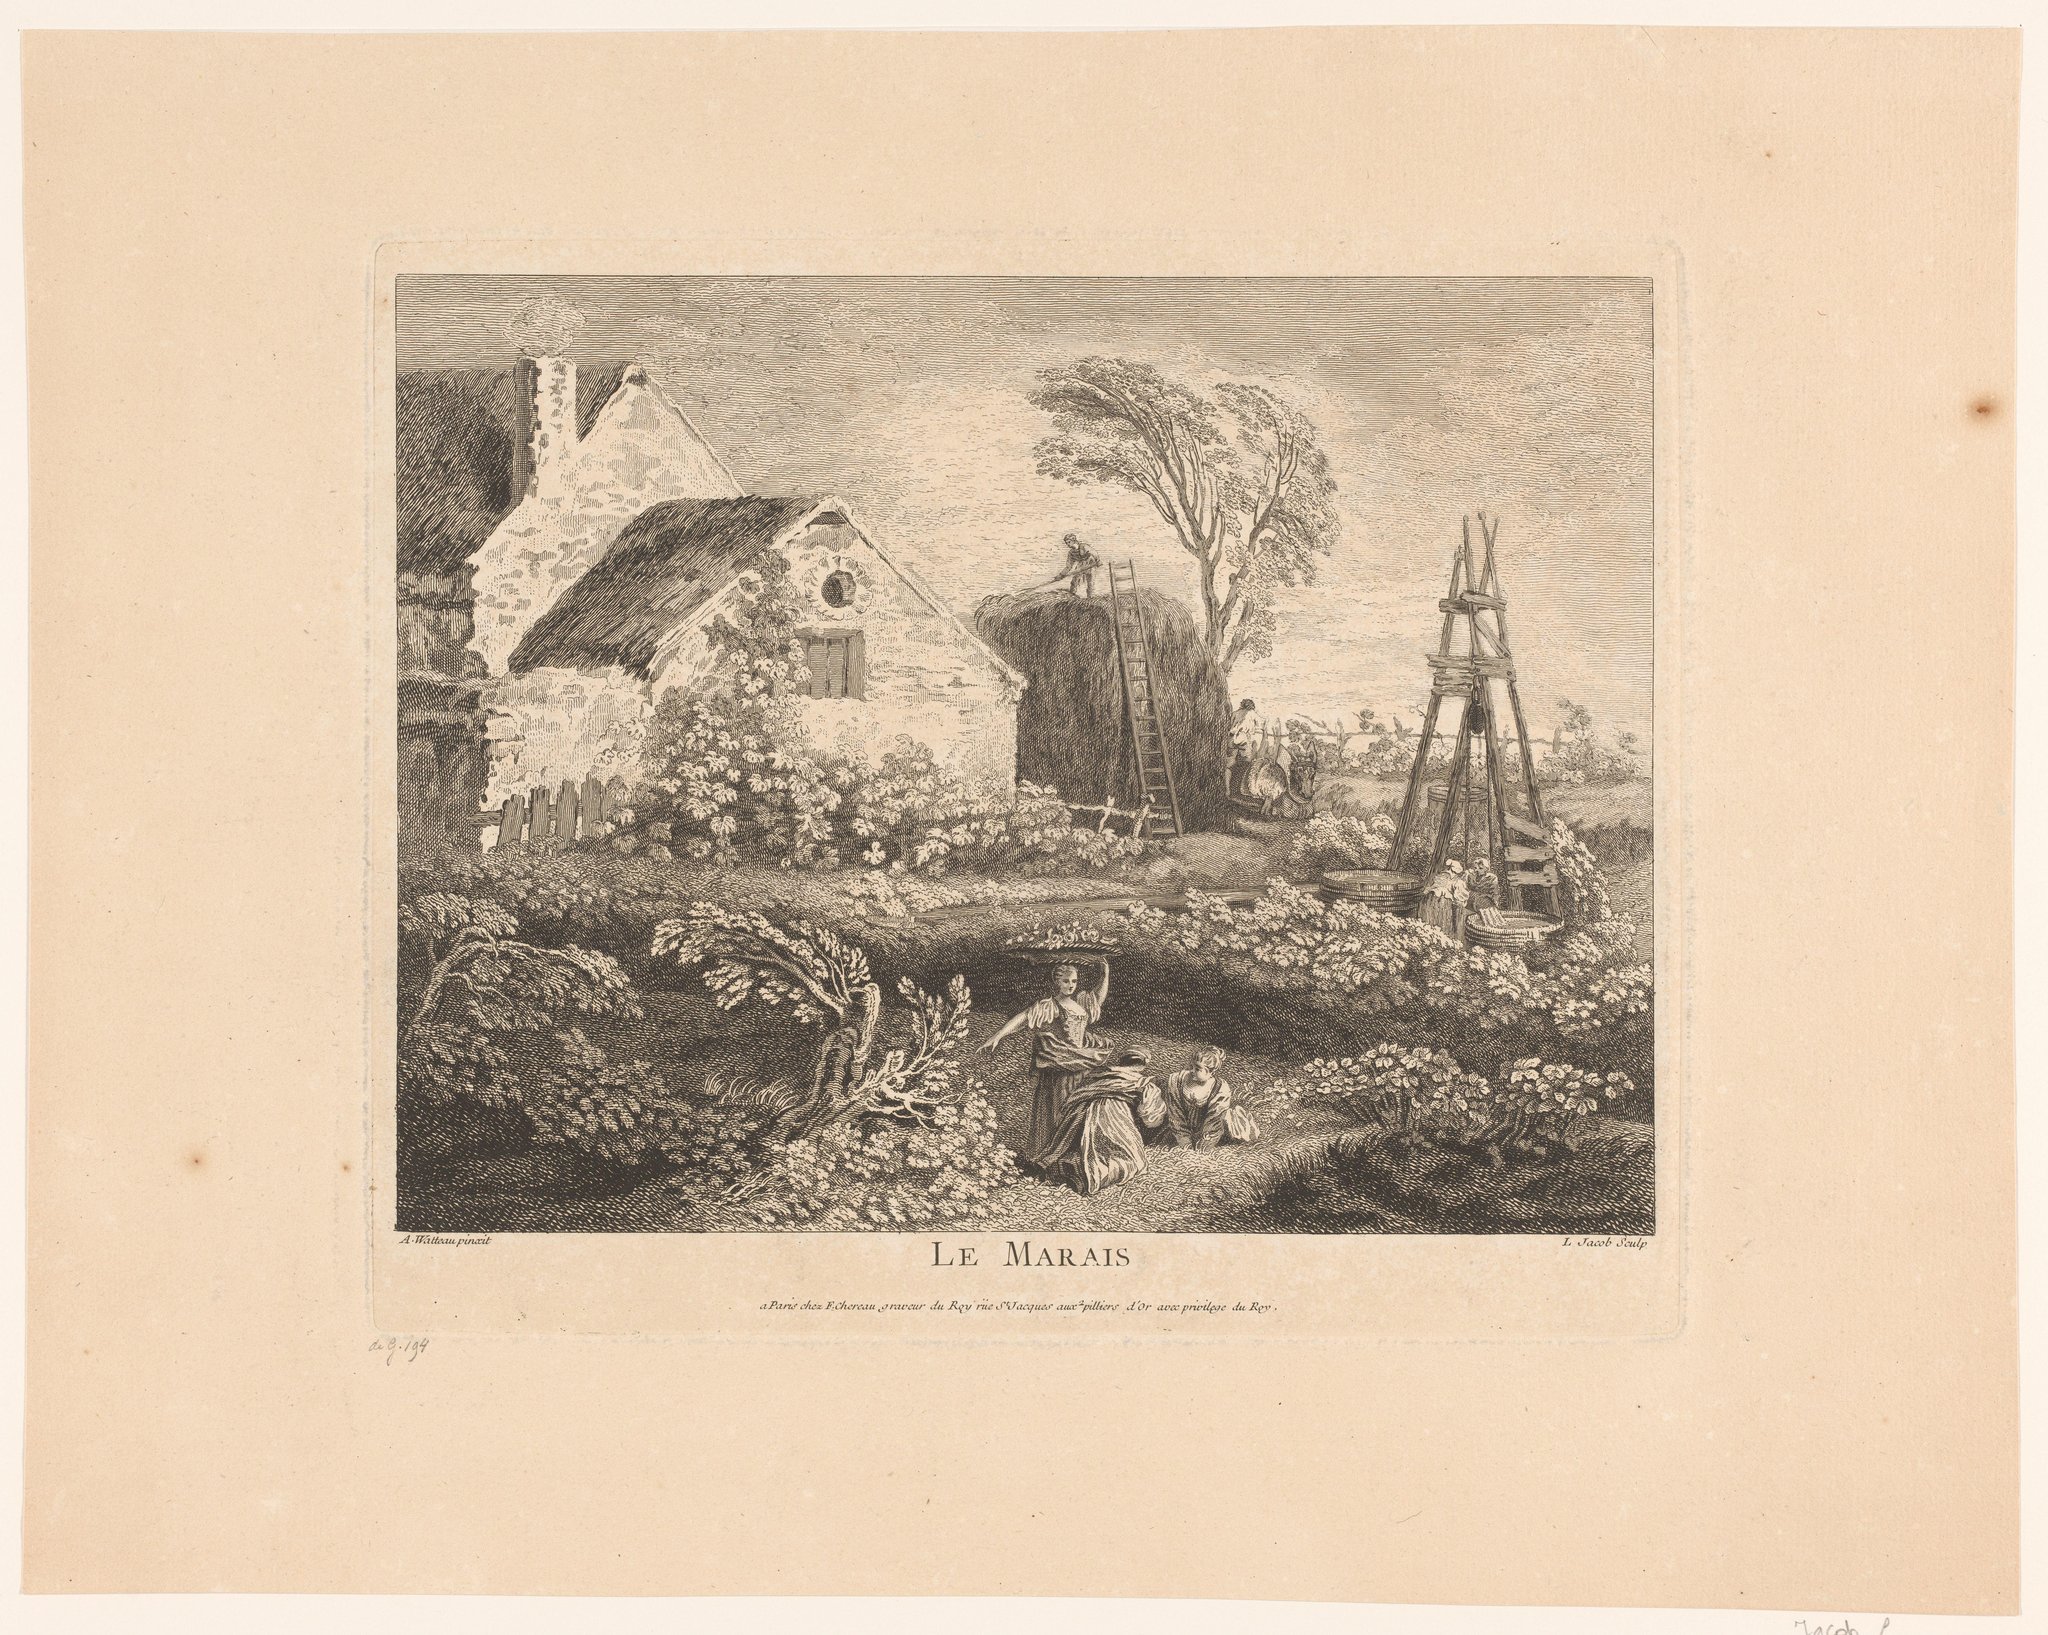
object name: print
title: L'Oeuvre d'Antoine Watteau Peintre du Roi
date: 1726-1729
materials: paper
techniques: etching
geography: paris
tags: rural housing, e.g. country-house, villa, cottage, hay-stack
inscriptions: watermark